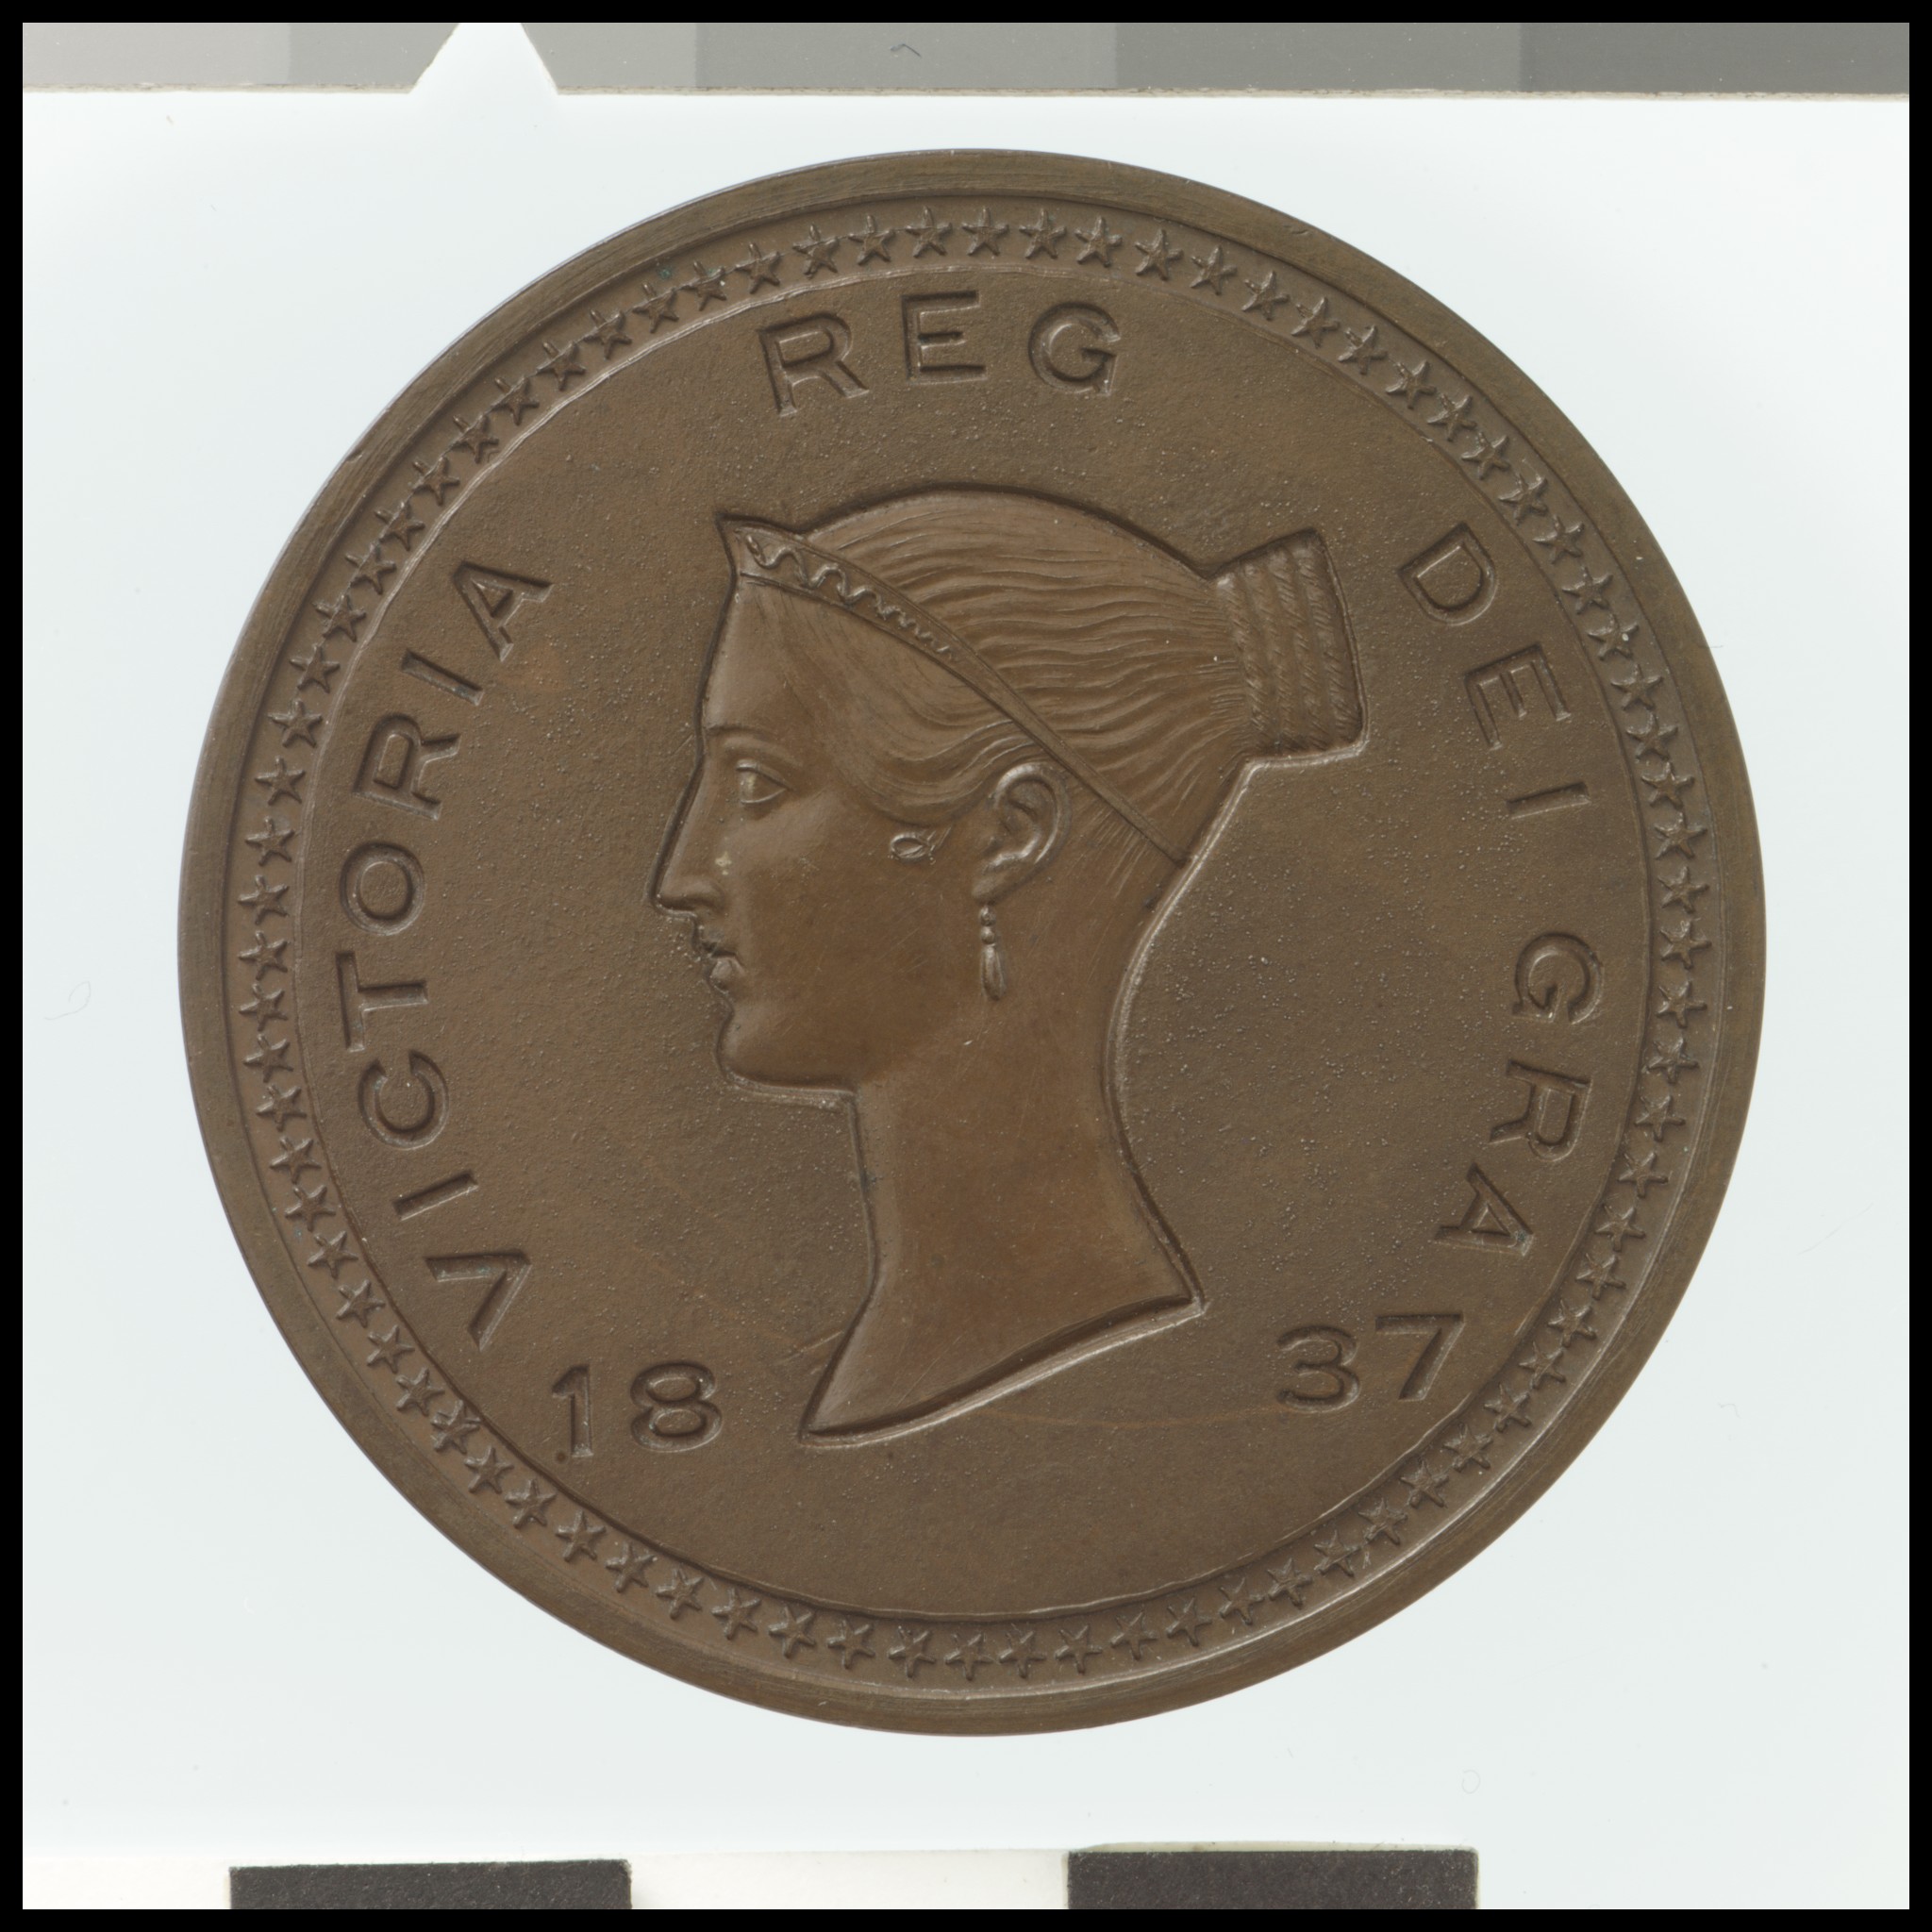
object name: pattern crown coin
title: Pattern crown of Queen Victoria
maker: joseph bonomi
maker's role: maker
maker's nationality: italian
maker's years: 1739-1808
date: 1837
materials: bronze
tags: profiles,women,queen victoria